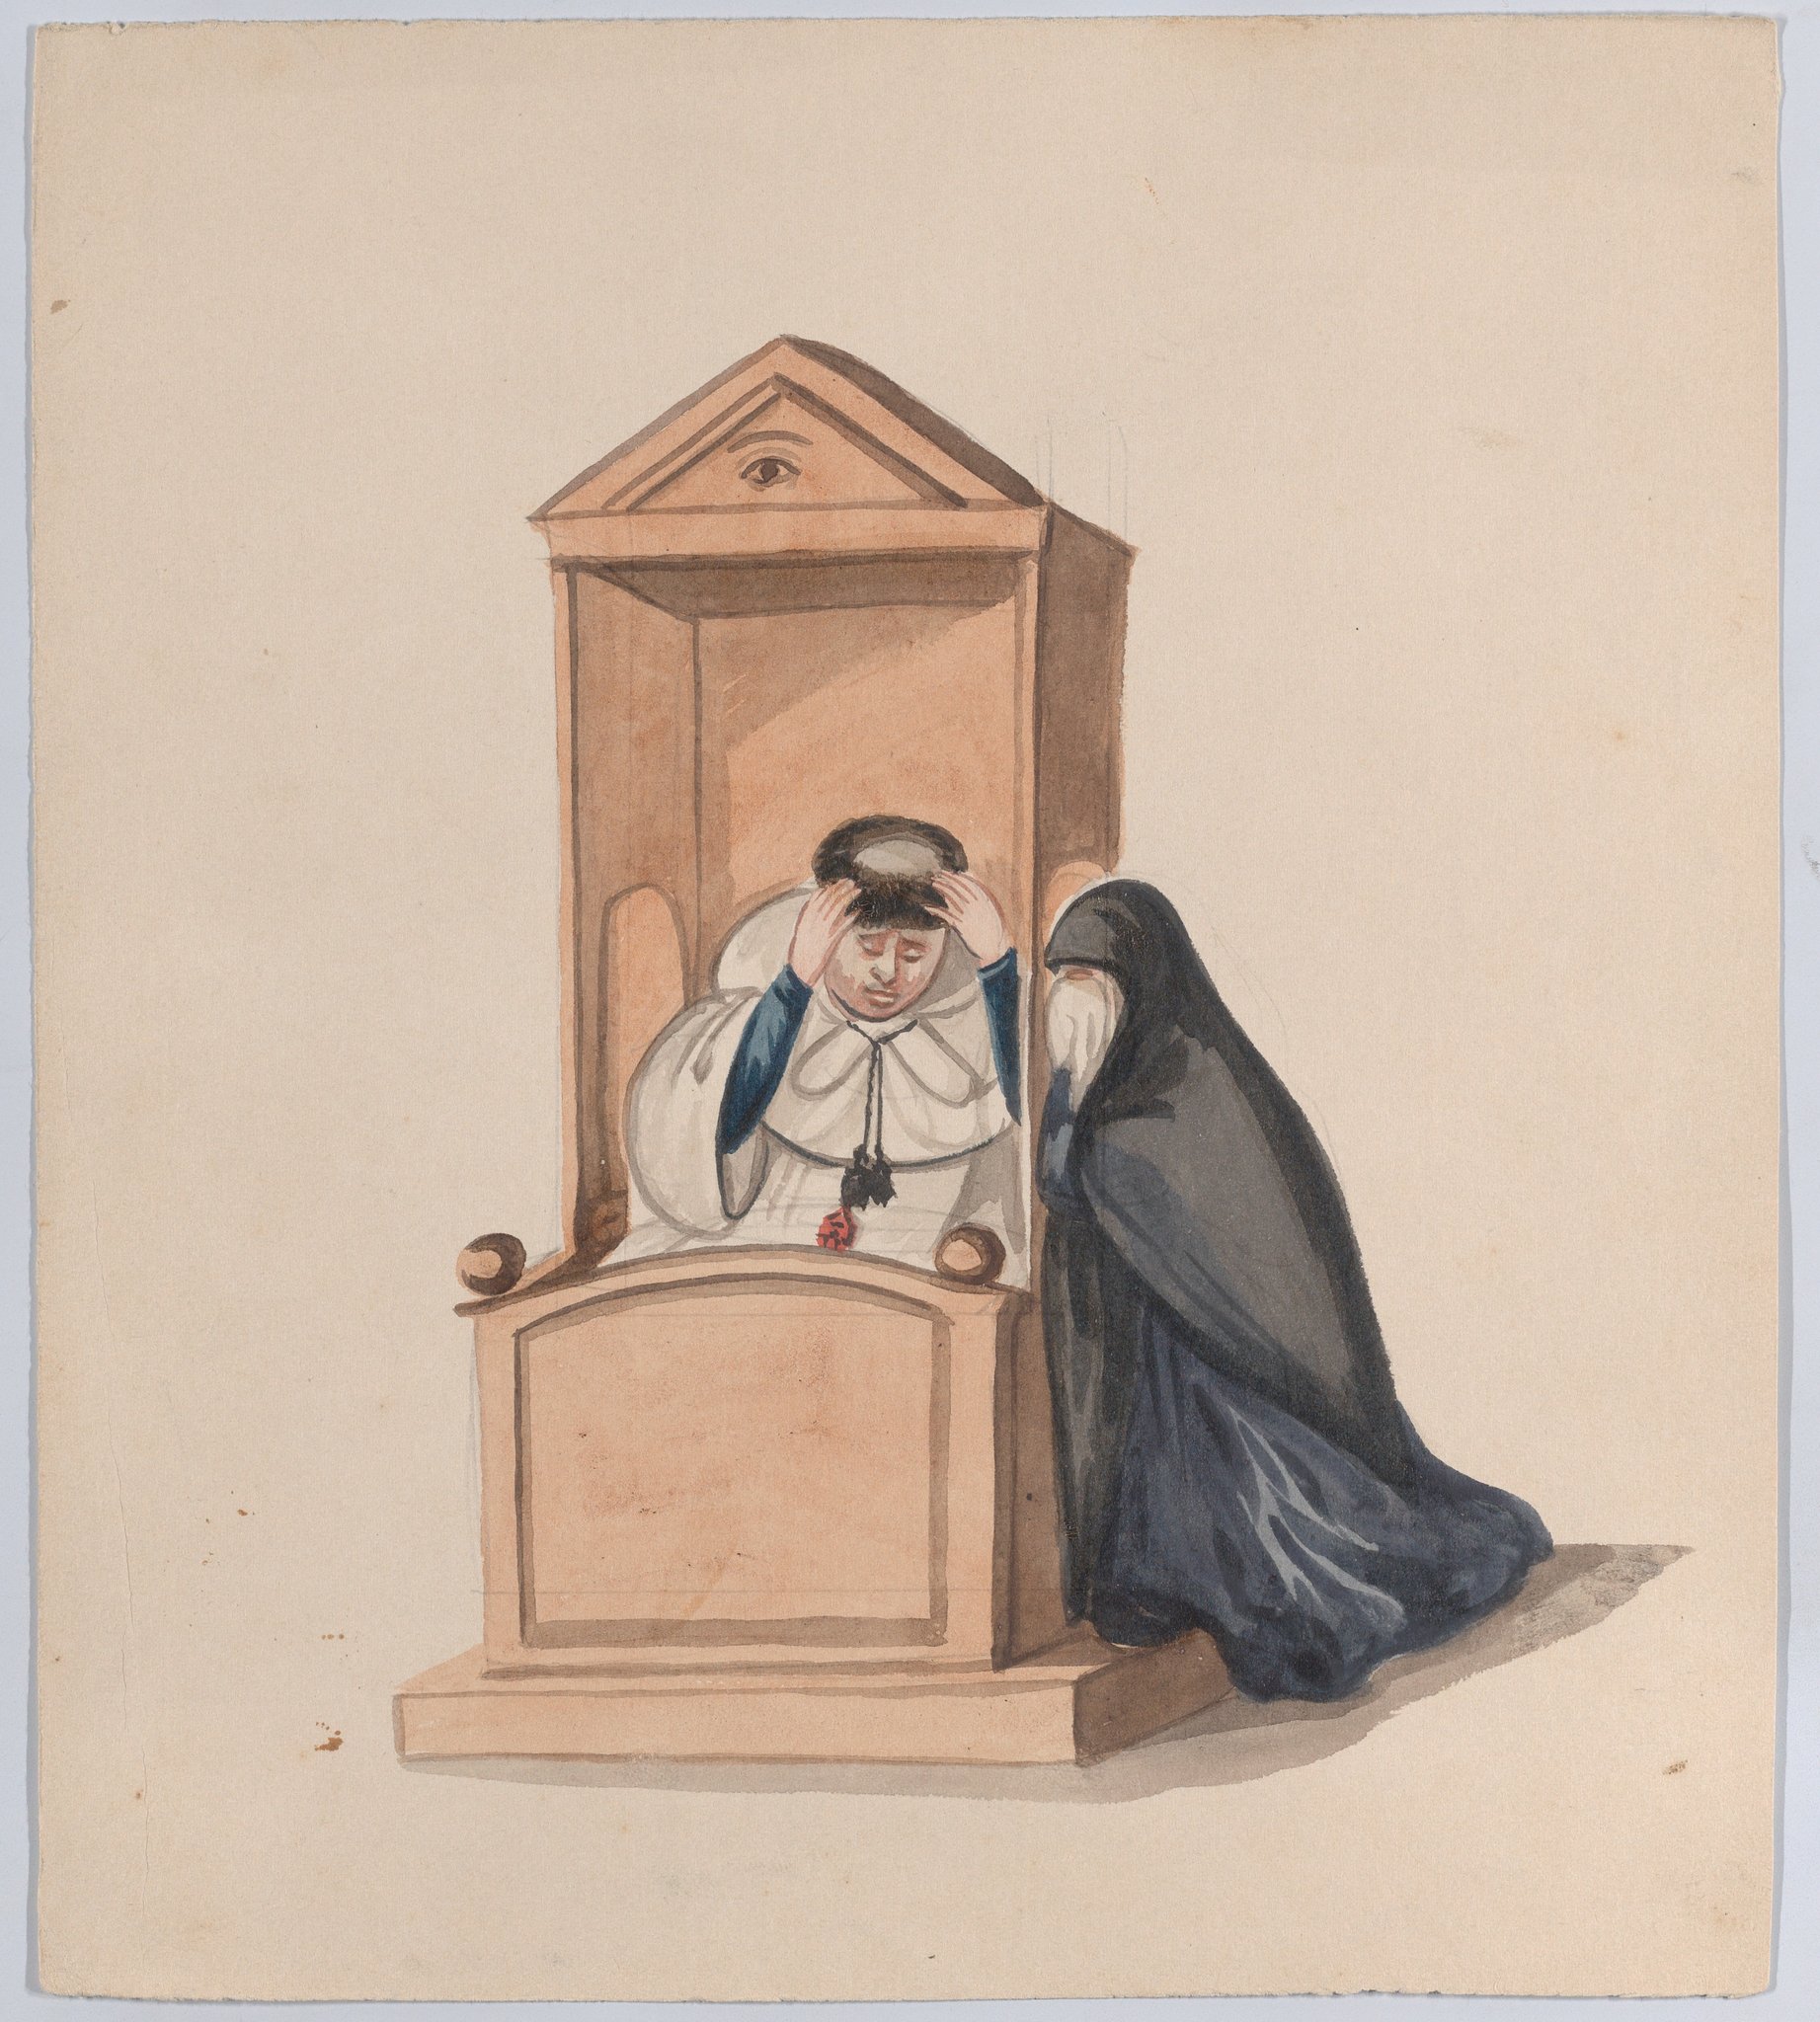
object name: drawing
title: A woman confessing to a priest, from a group of drawings depicting Peruvian dress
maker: francisco (pancho) fierro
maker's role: artist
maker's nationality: african peruvian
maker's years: 1807-1879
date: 1848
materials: watercolor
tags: men,women